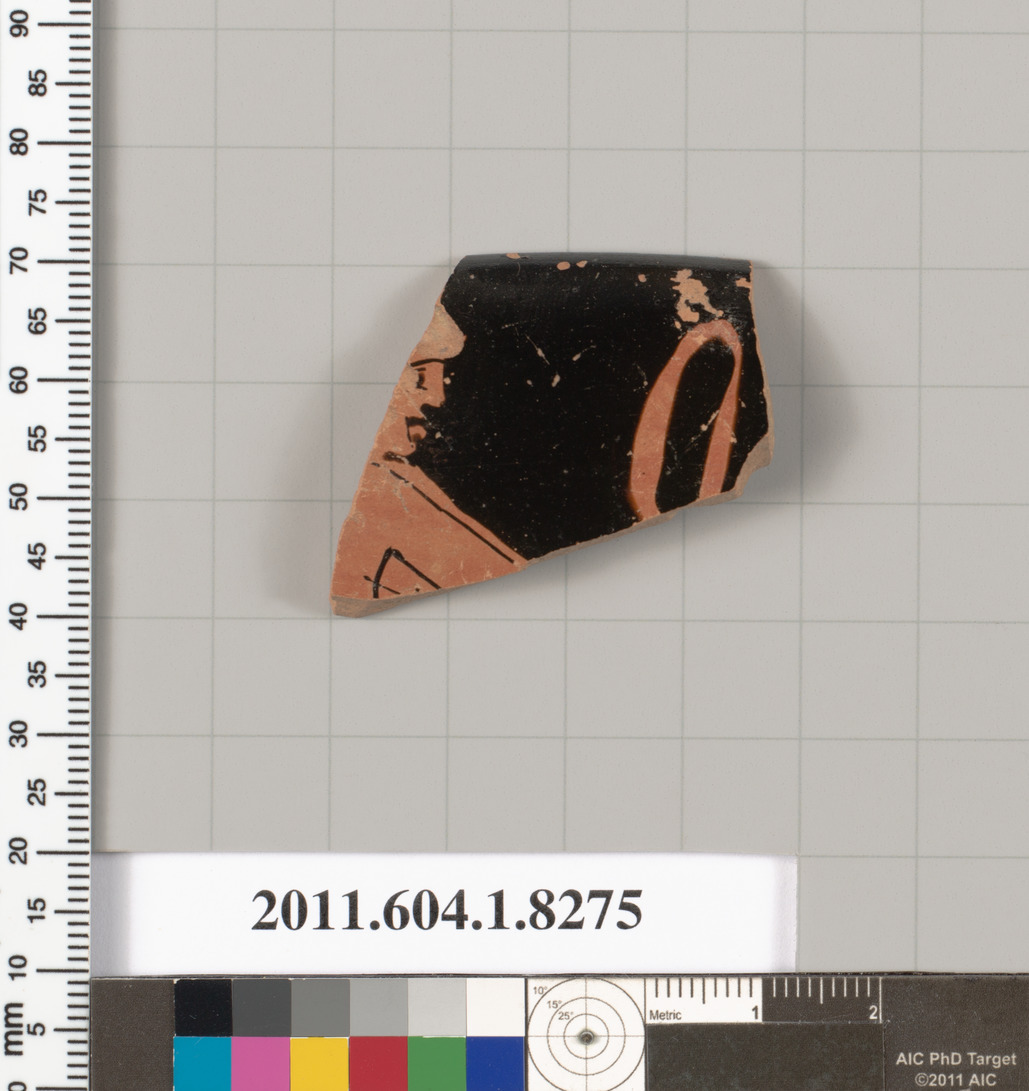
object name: kylix fragment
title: Terracotta rim fragment of a kylix (drinking cup)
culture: greek, attic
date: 400-351 BCE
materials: terracotta